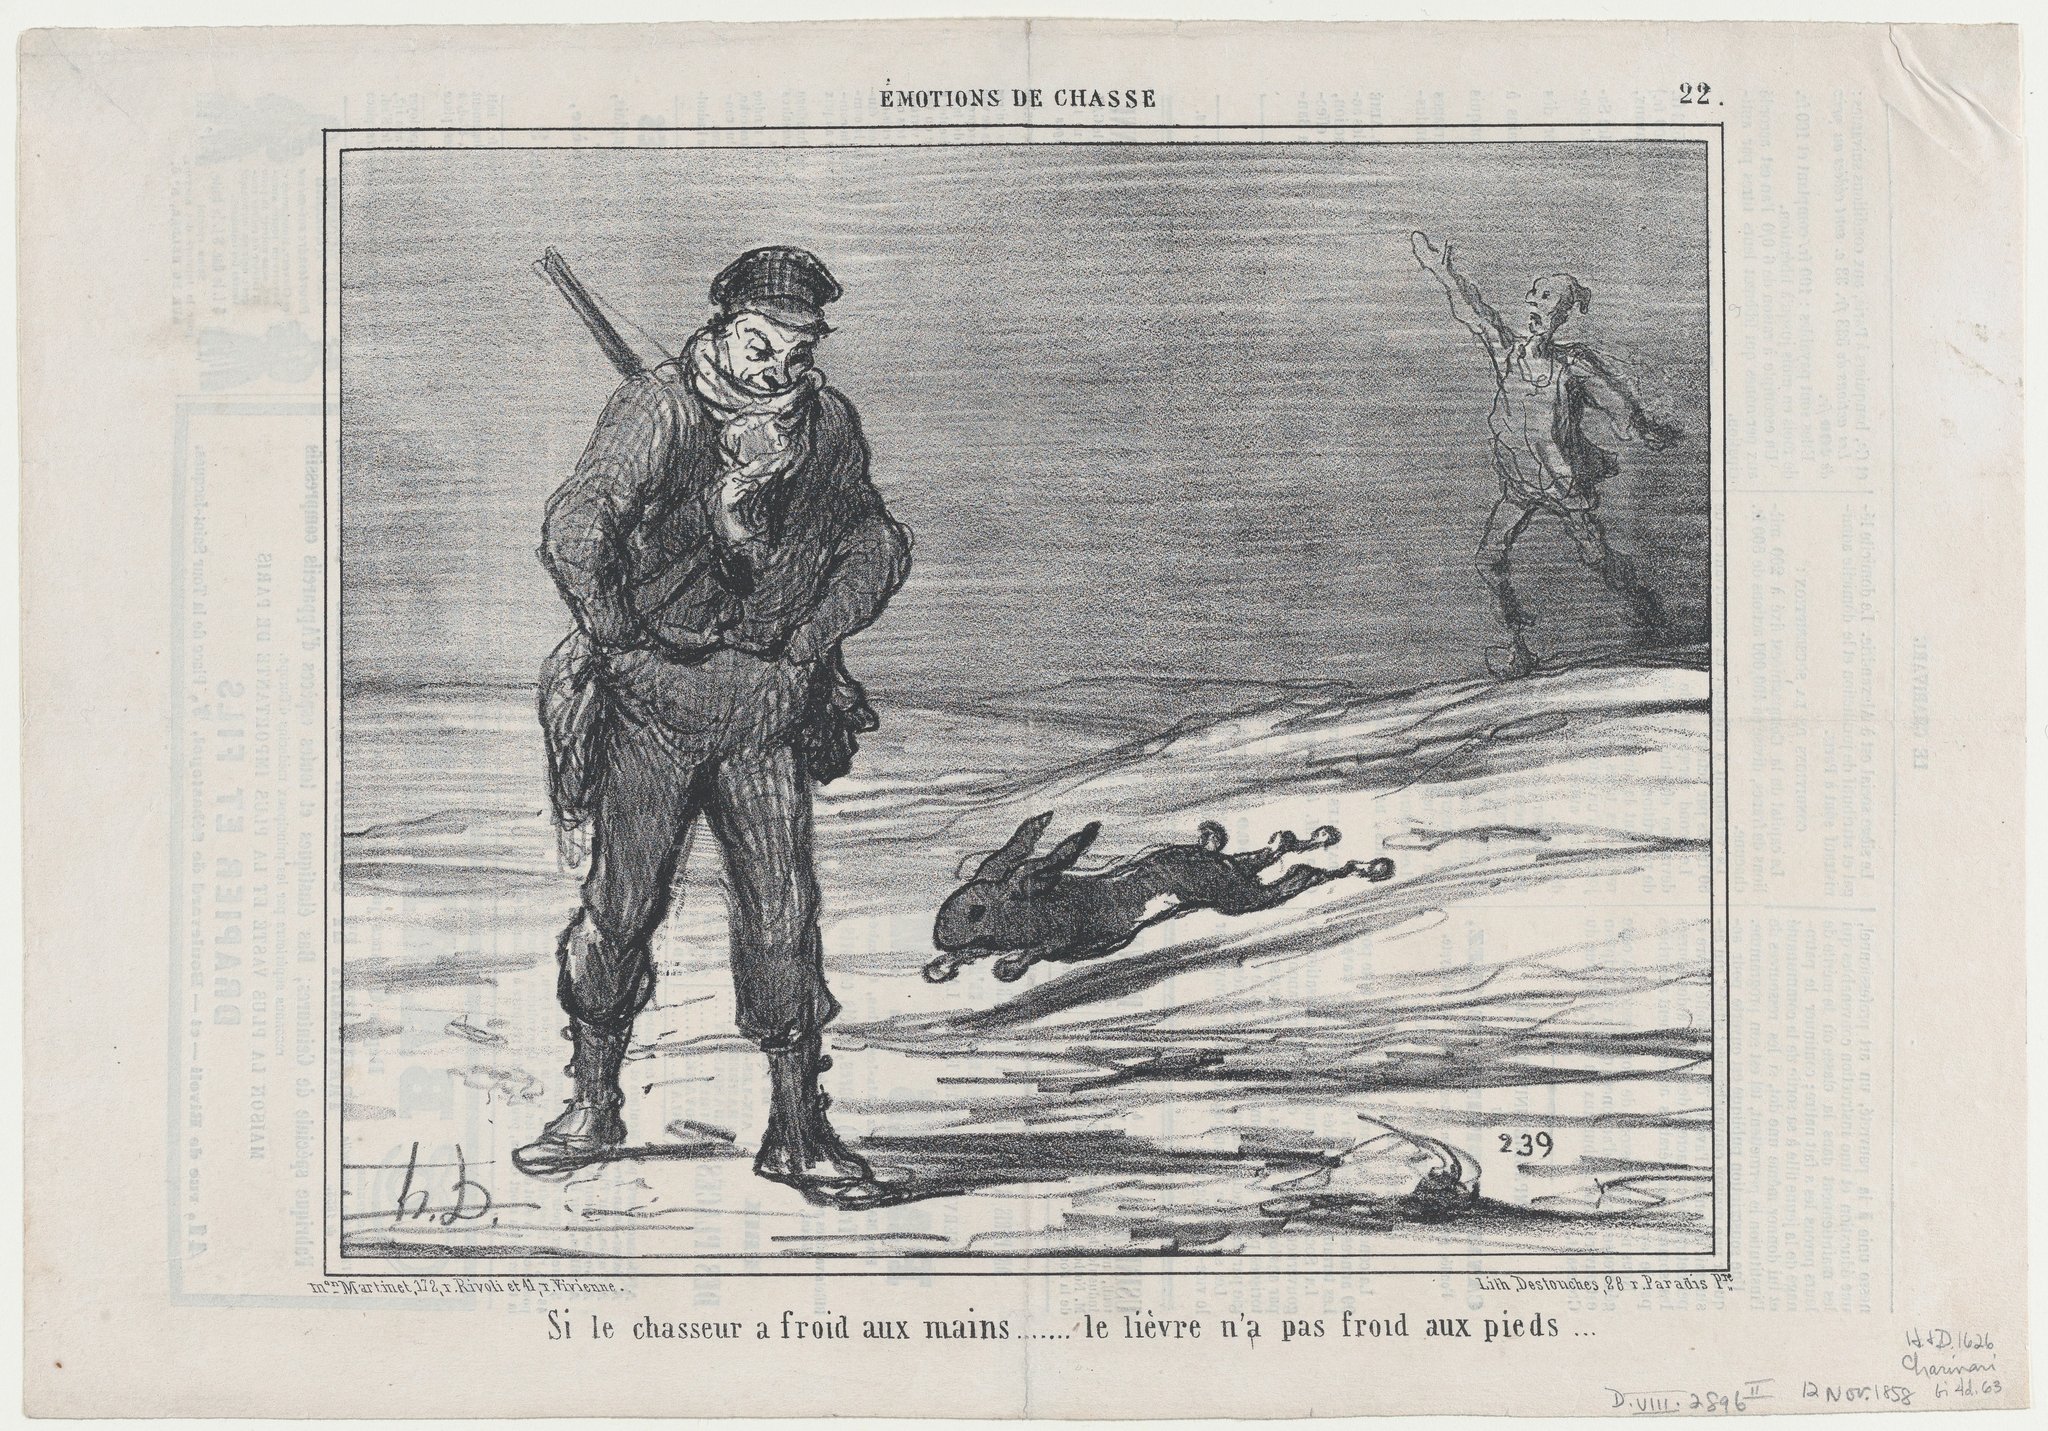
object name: print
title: Si le chassuer a froid aux mains..... le lièvre n'a pas froid aux pieds..., from Émotions de Chasse, published in Le Charivari, November 12, 1858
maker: honoré daumier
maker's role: artist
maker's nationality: french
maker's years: 1808-1879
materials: paper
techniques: lithograph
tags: men,hunting,rabbits